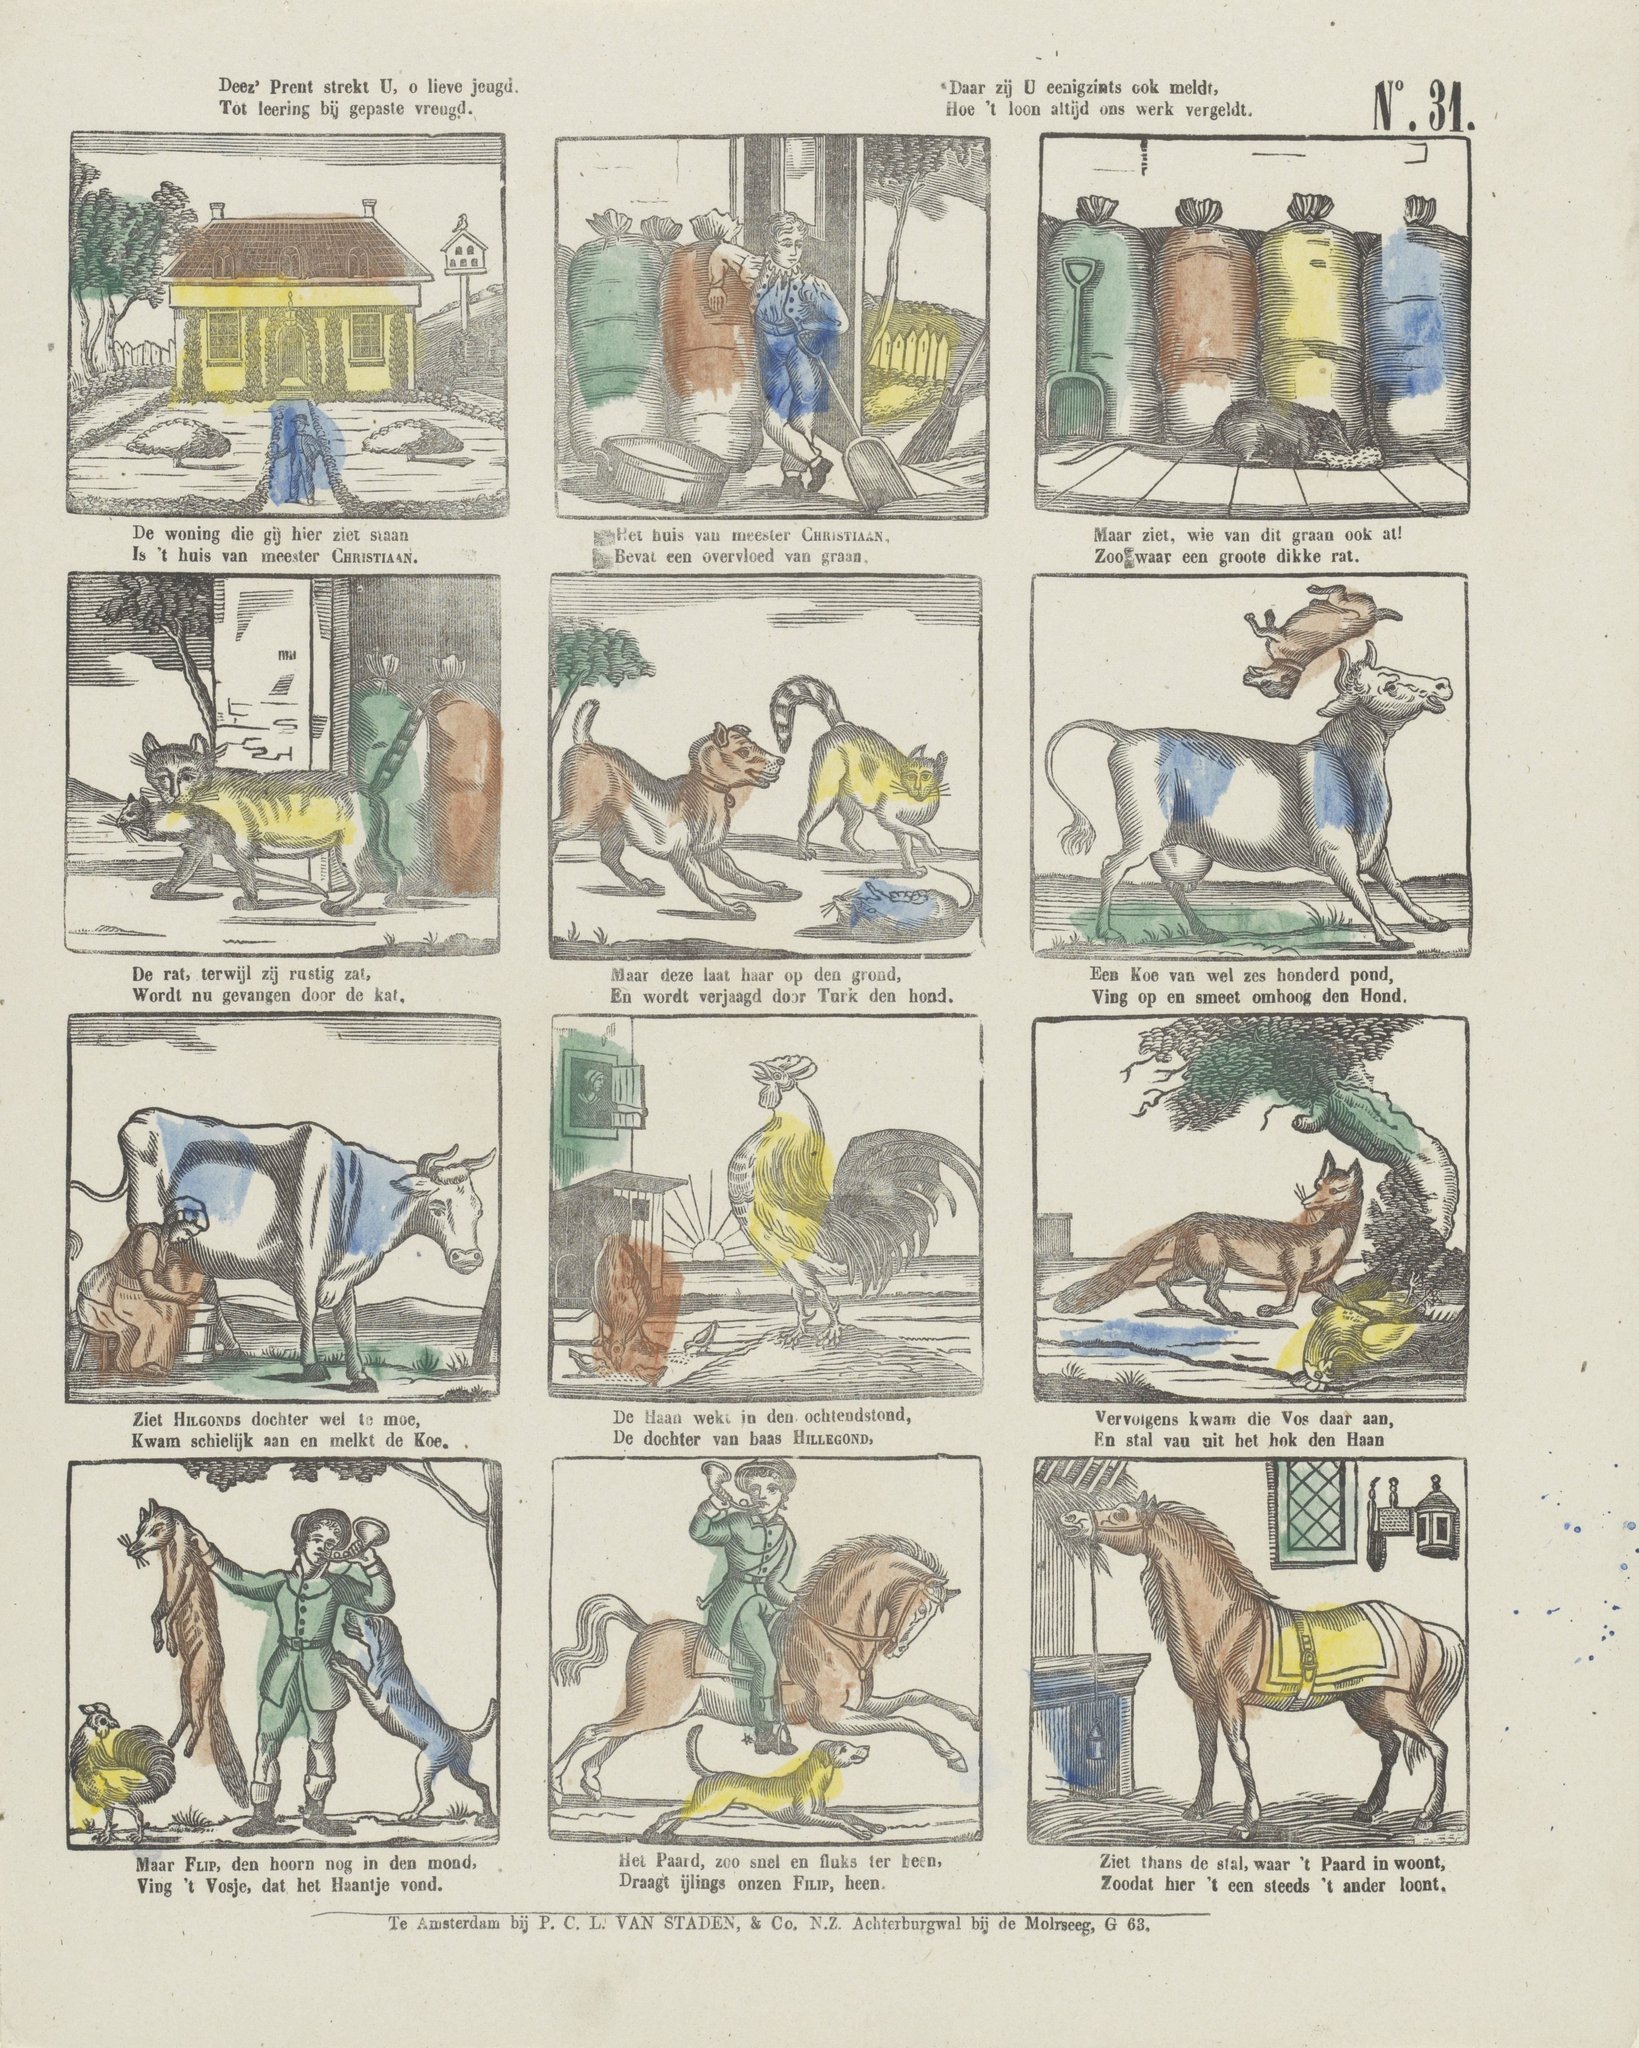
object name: popular print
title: Deez' prent strekt u, o lieve jeugd, / Tot leering bij gepaste vreugd. / Daar zij u eenigzins ook meldt, / Hoe 't loon altijd ons werk vergeldt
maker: willem bal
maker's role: print maker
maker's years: 1808-1897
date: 1850-1870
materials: paper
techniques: colour, letterpress printing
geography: netherlands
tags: cow, animals, rodents: rat, cat, farmers, fowl (cock, hen, chicken, etc.), horse, dog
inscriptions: collector's mark: Lugt 2760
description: Blad met 12 voorstellingen van mensen en dieren op de boerderij. Onder elke voorstelling een tweeregelig vers. Rechtsboven genummerd: No. 31.